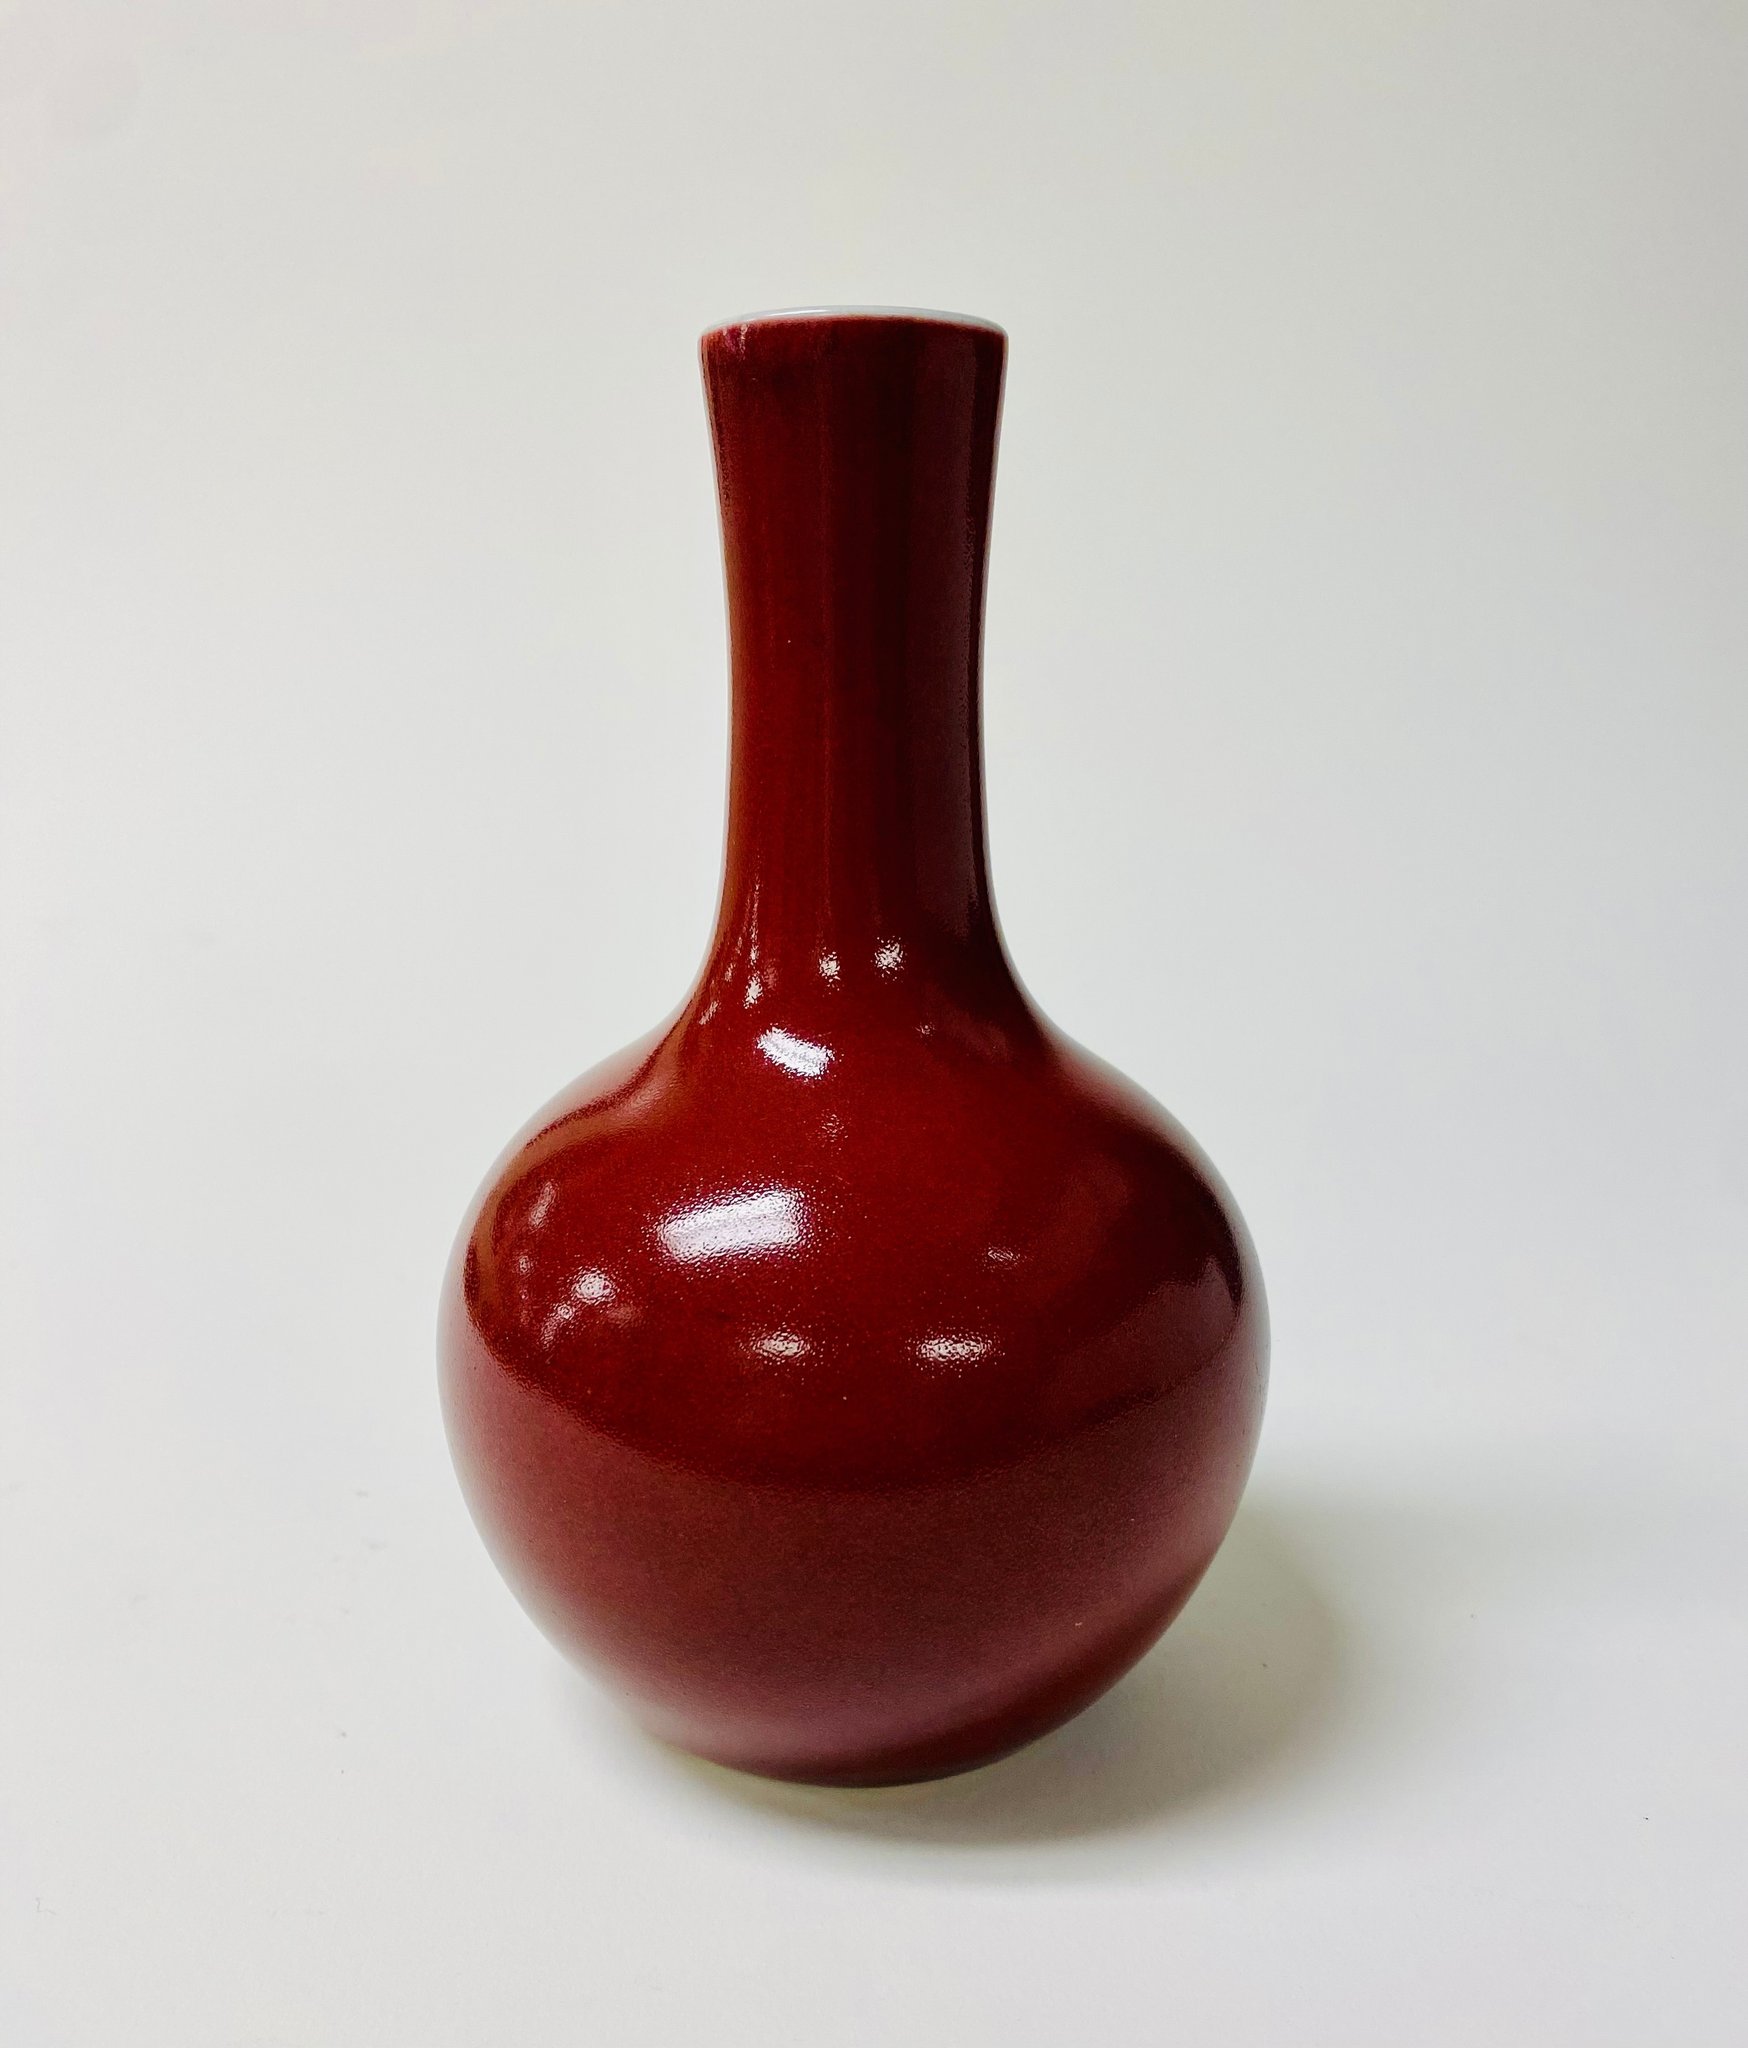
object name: bottle vase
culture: chinese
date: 1701-1800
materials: copper, glaze, porcelain